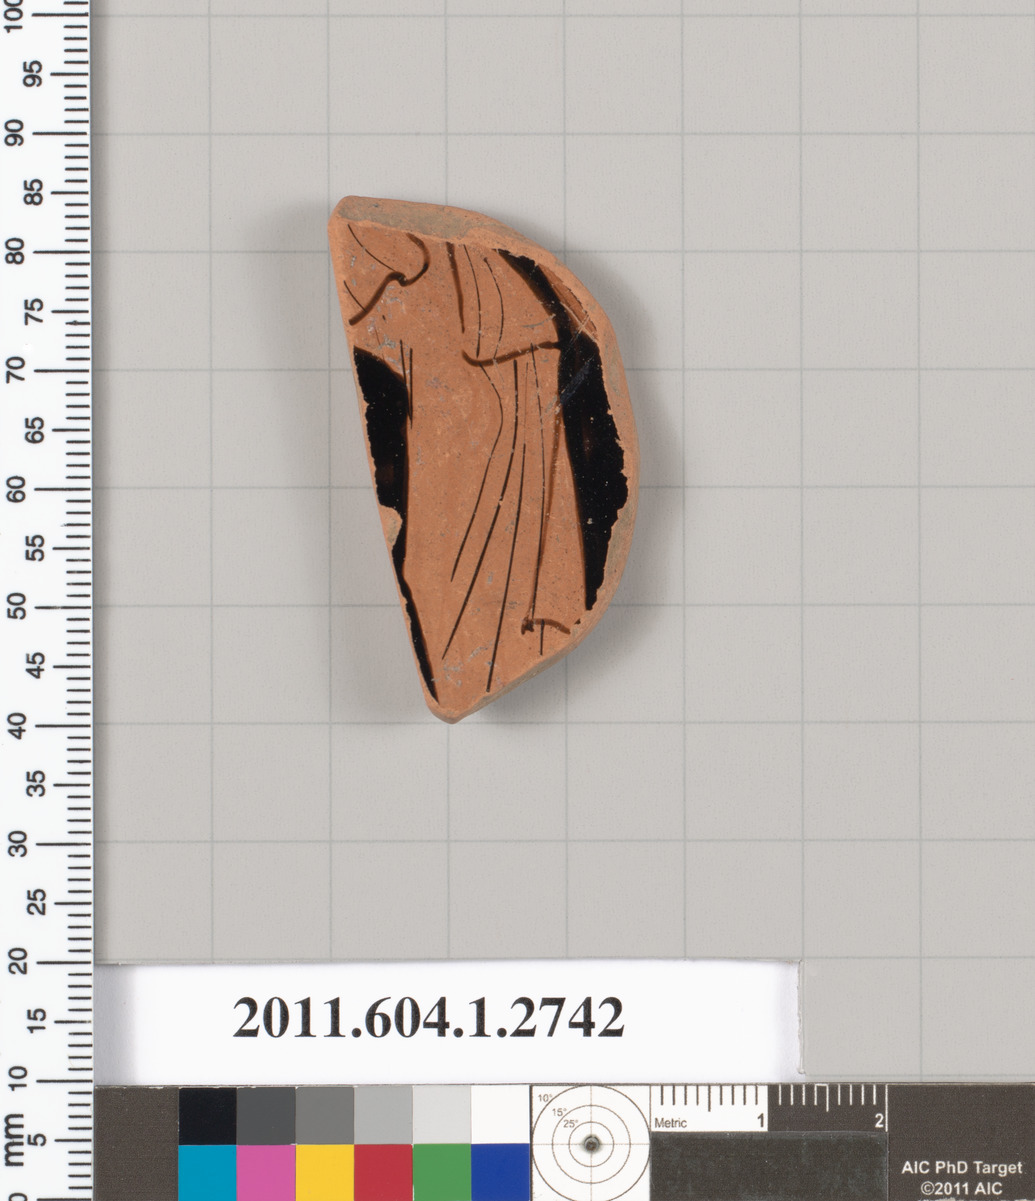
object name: kylix fragment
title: Terracotta fragment of a kylix (drinking cup)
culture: greek, attic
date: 467-435 BCE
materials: terracotta